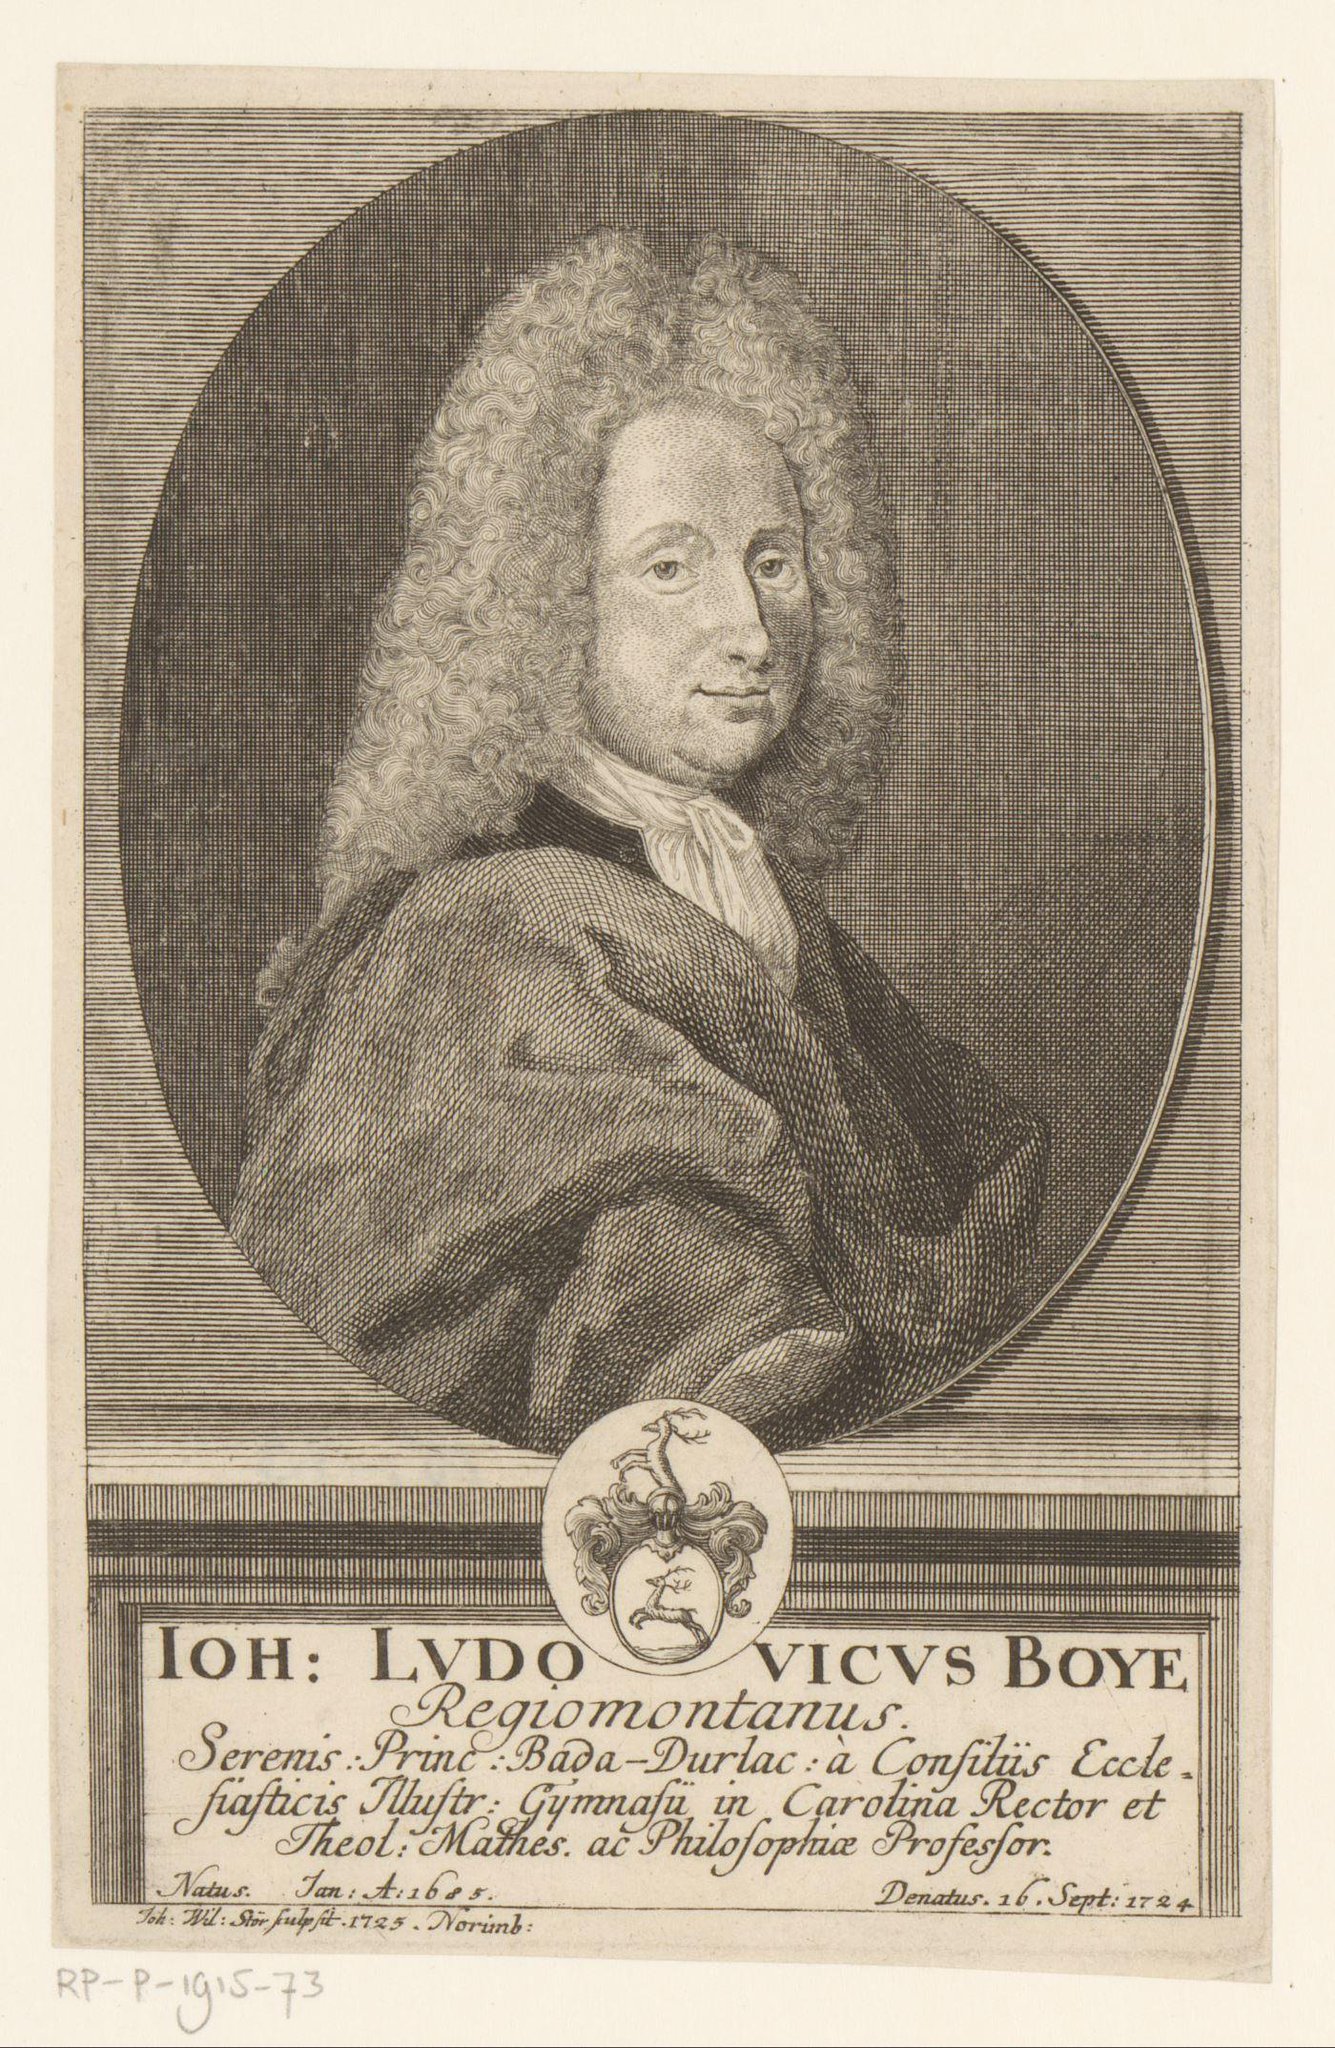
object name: print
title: Portret van Johann Ludwig Boye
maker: johann wilhelm stör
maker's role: draughtsman, print maker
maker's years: 1705-1765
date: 1725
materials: paper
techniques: engraving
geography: nuremberg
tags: historical persons, armorial bearing, heraldry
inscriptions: collector's mark: Lugt 2228